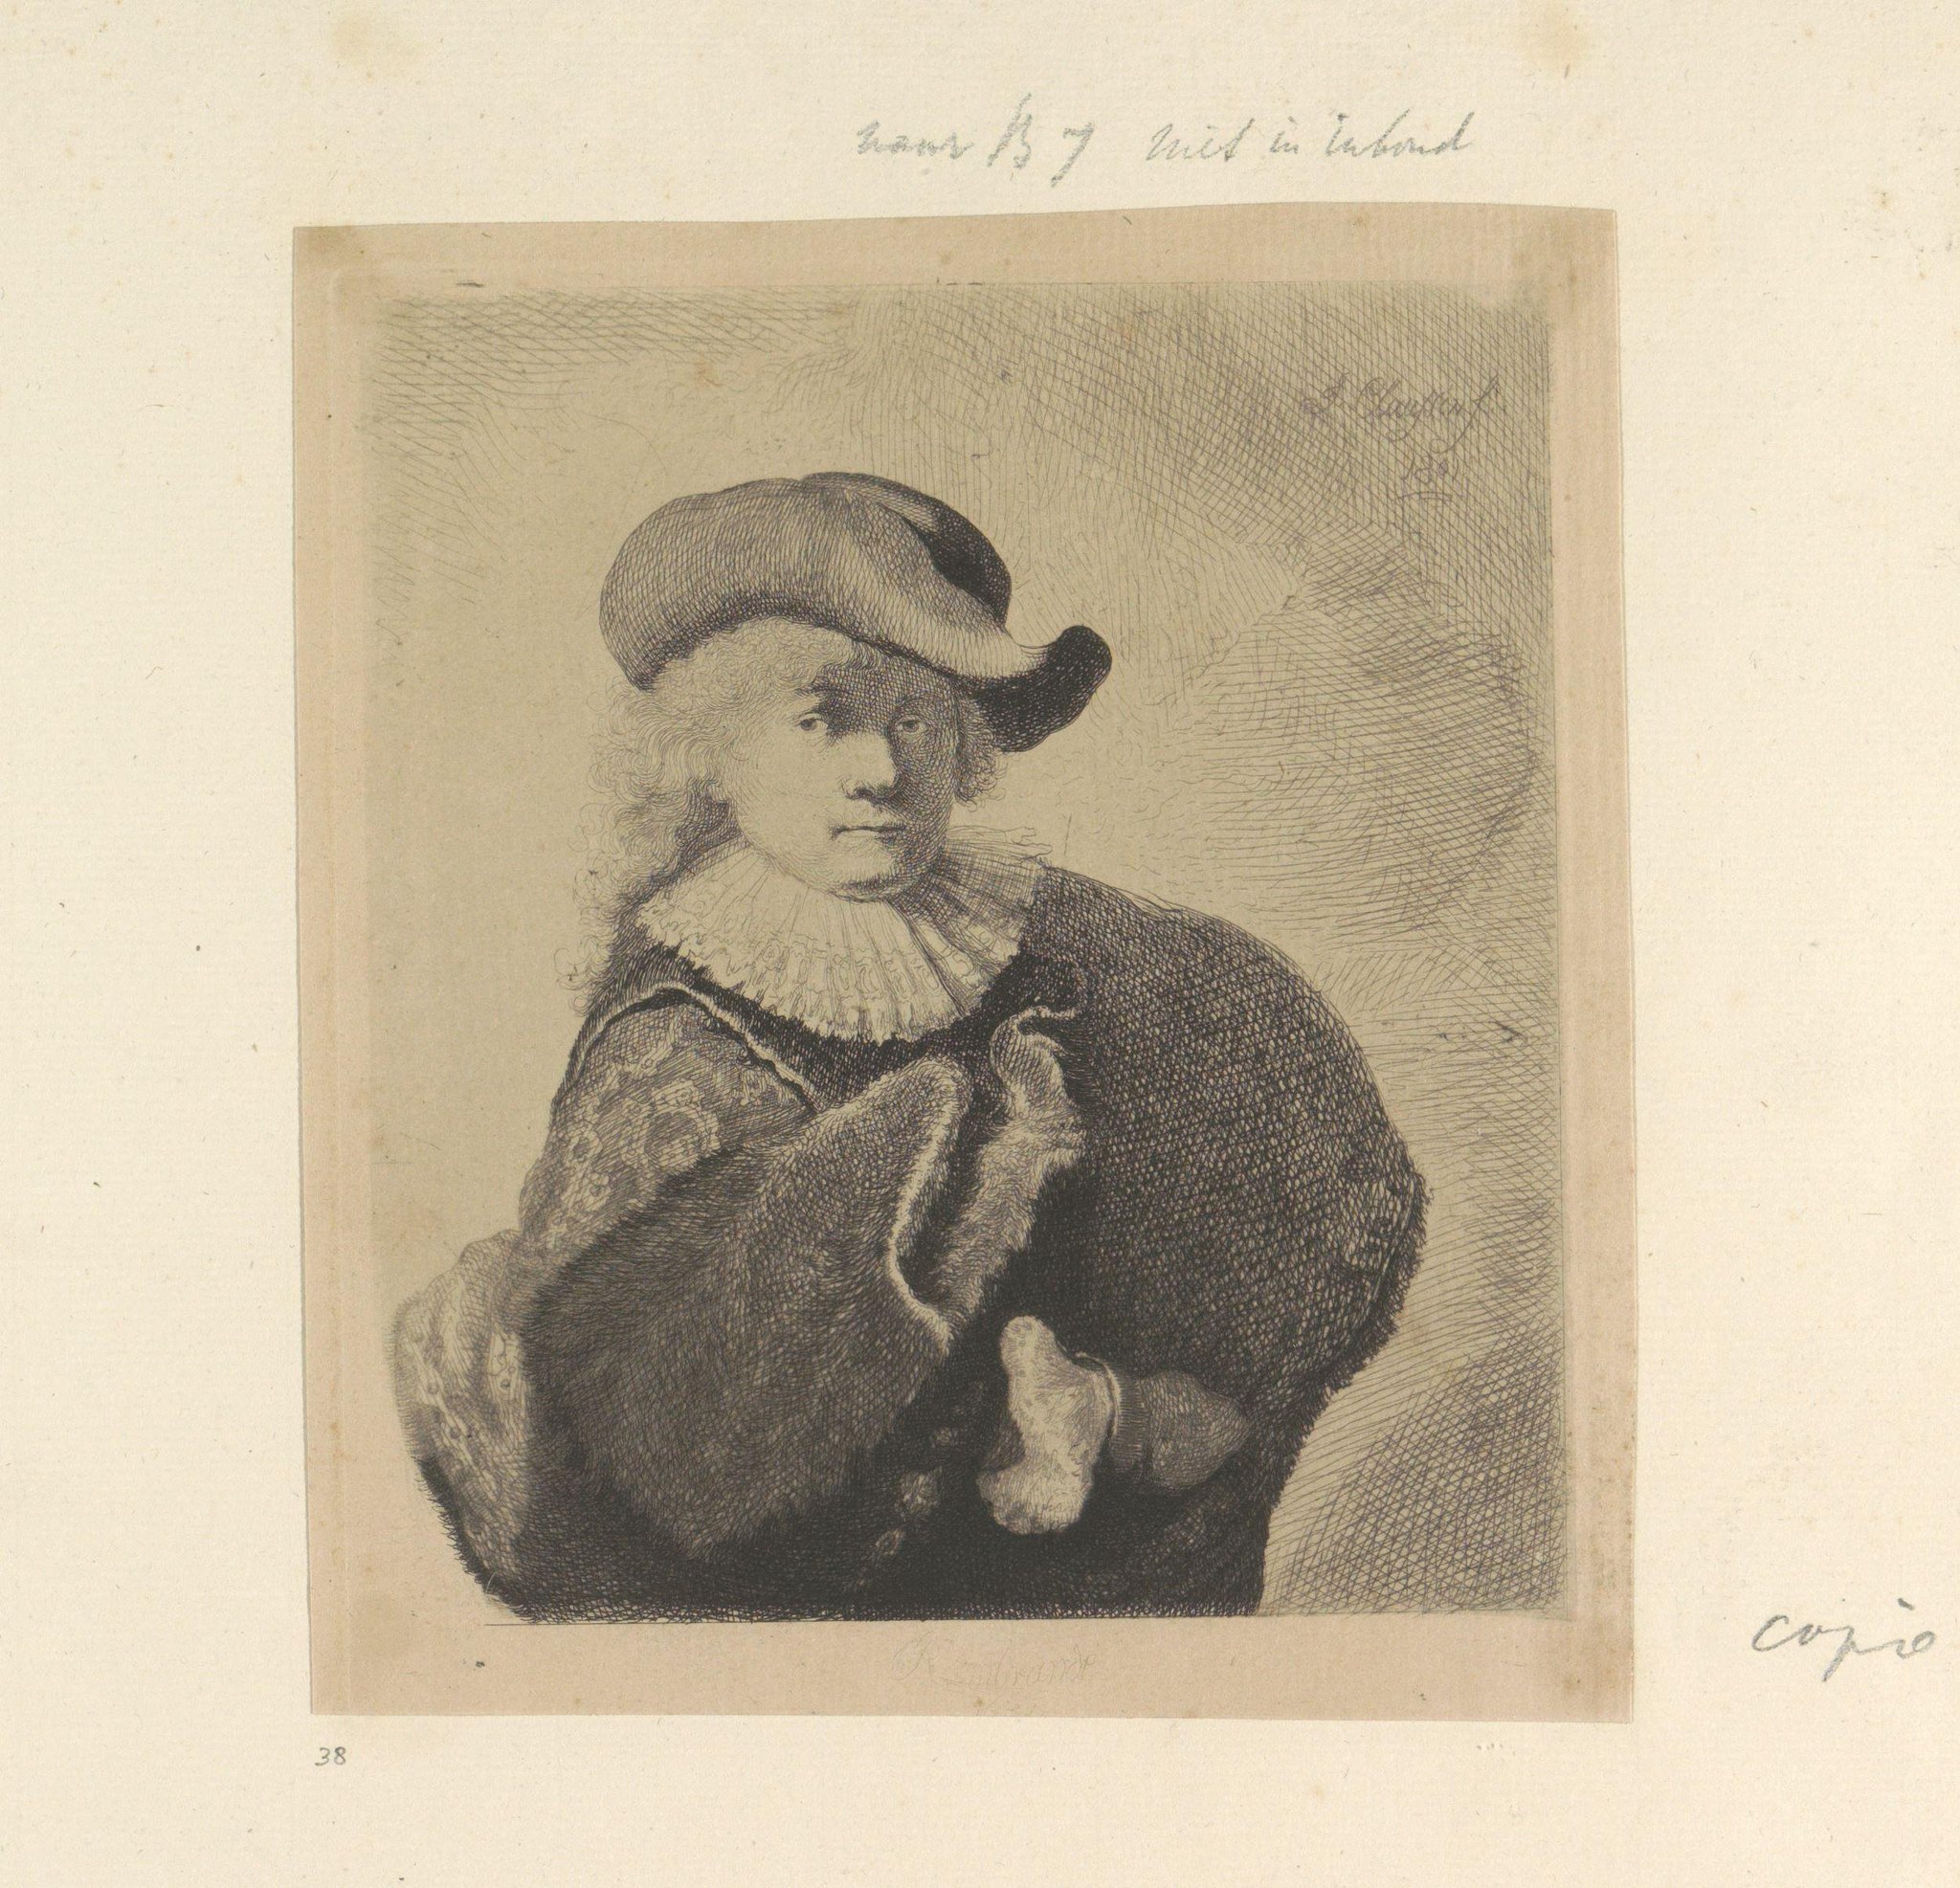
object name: album leaf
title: Zelfportret met hoed met slappe rand en geborduurde mantel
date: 1801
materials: paper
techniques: etching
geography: paris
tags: leiden, amsterdam, painter, draughtsman, rembrandt van rijn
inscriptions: date